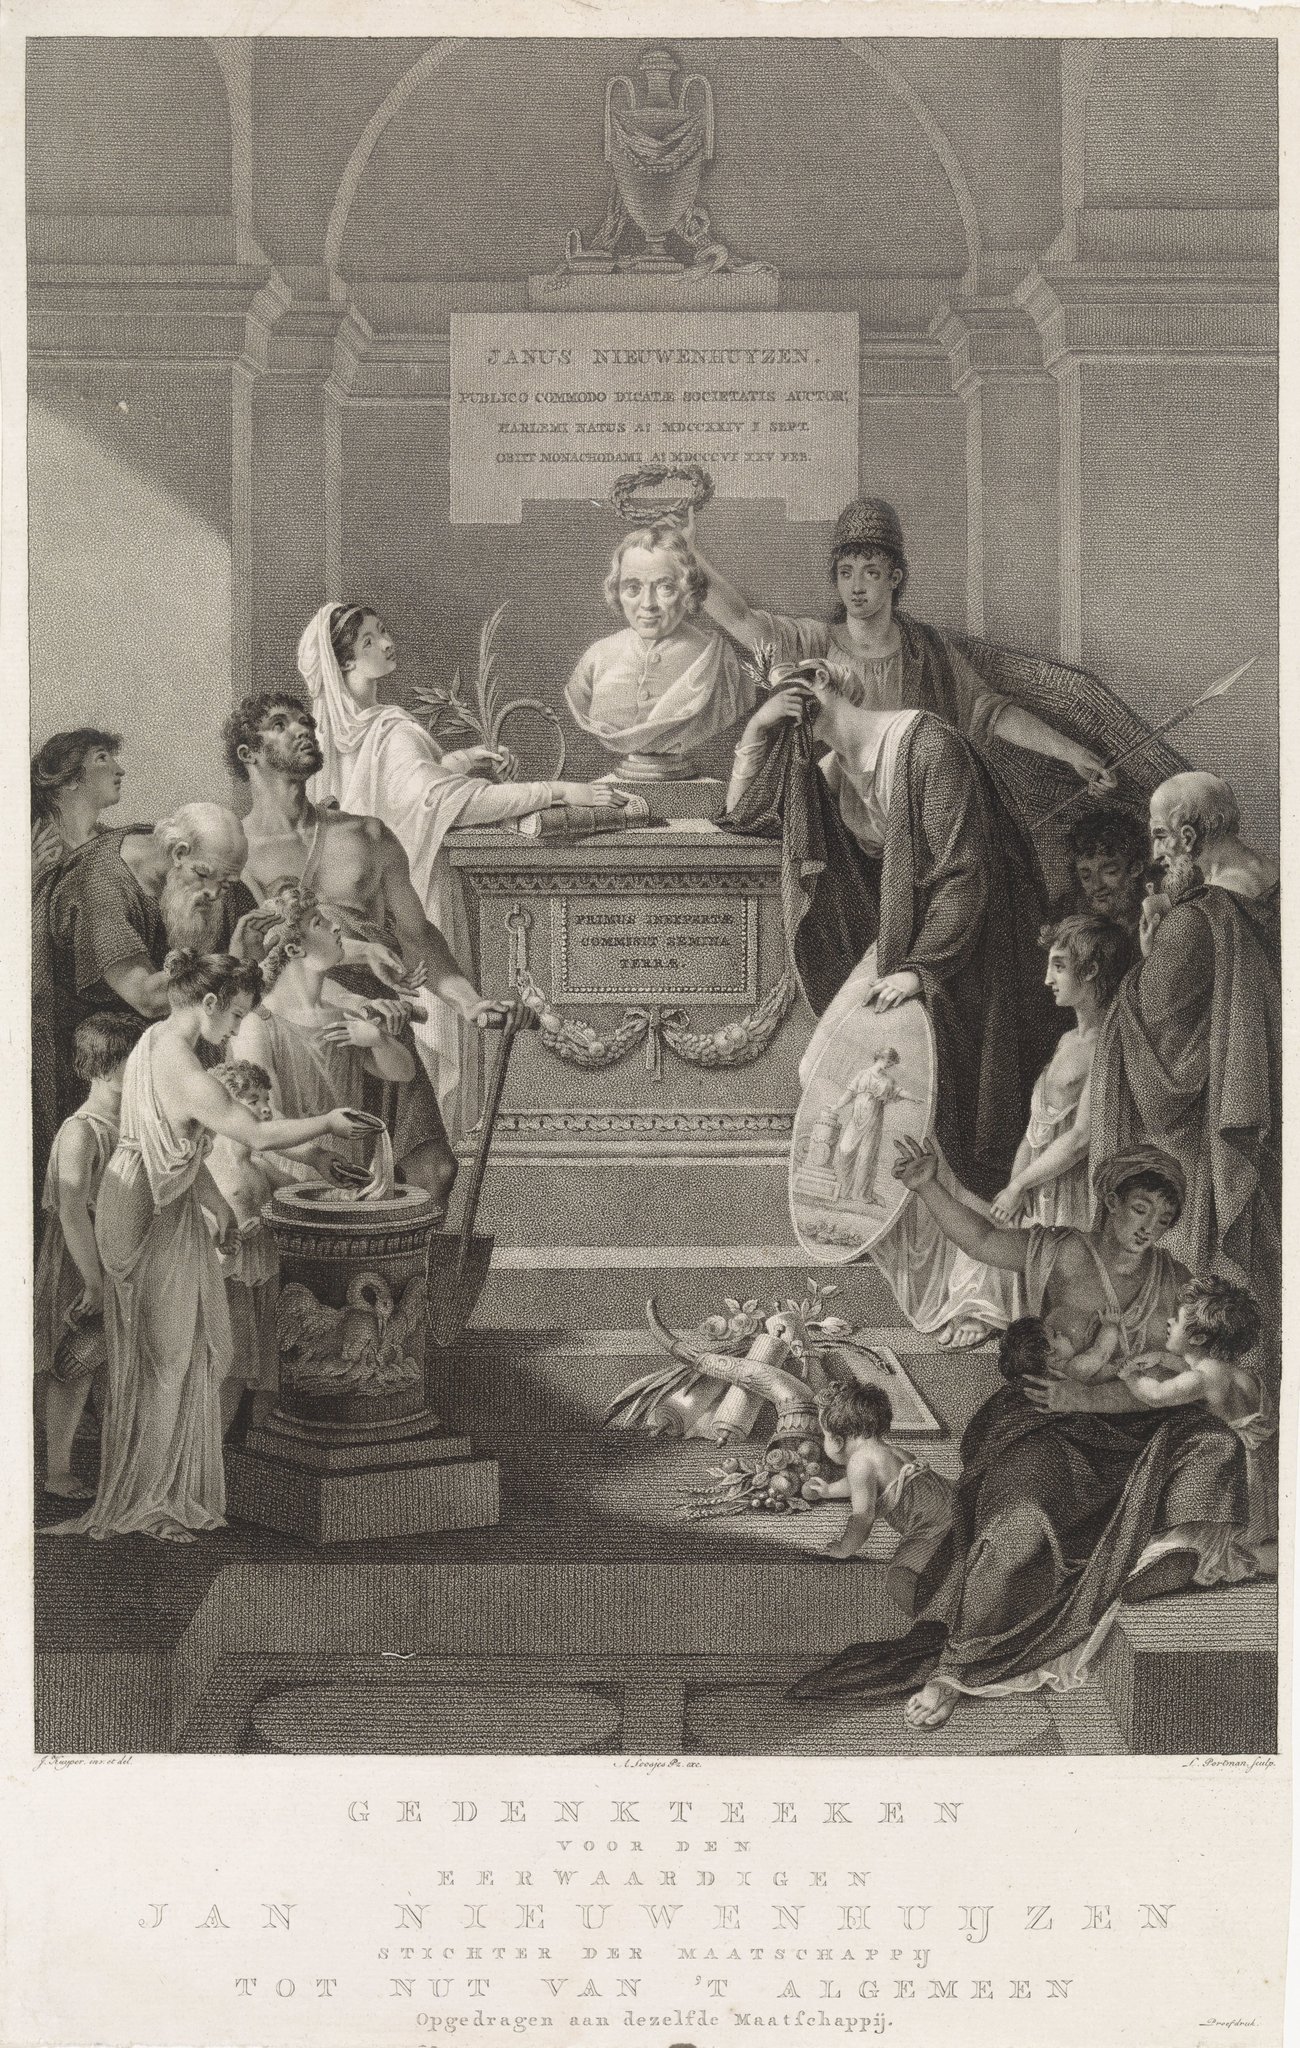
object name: print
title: Gedenkteeken voor den eerwaardigen Jan Nieuwenhuijzen stichter der maatschappij Tot nut van 't algemeen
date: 1806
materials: paper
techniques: etching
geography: amsterdam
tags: haarlem, jan nieuwenhuyzen, 'cornucopia', horn of plenty, charity, 'caritas'; 'carità' (ripa) ~ one of the three theological virtues, offering; 'offerta overo oblatione' (ripa) (+ allegorical scene, i.e. two or more personifications involved in an action), symbols, allegories of peace, 'pax'; 'pace' (ripa), serpent ouroboros, urn, crowning with laurel, love towards god; 'amore verso iddio' (ripa), grave, tomb and other grave-forms and grave-markers, youth, adolescence, 'iuventus'; 'adolescenza', 'gioventù' (ripa), the bible as a book, symbols of particular nations, states, districts, etc.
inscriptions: collector's mark: Lugt 2228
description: Gedenksteen voor Jan Nieuwenhuyzen, overleden 25 februari 1806. Op een altaar in een nis staat de buste van Jan Nieuwenhuyzen, stichter van de Maatschappij Tot Nut van 't Algemeen. Daarboven een kader met de naam, geboorte- en sterfdatum van Nieuwenhuyzen. Op het altaar een motto in het Latijn (Hij plantte daar niets stond). De buste wordt gelauwerd door de Hollandse Maagd. Voor haar de personificatie van de Maatschappij die haar betraande gezicht bedekt en leunt op het altaar en haar schild. Aan de andere kant van het altaar kijkt de Godsvrucht op naar de buste. Haar hand rust op een bijbel (Zaligheid), in de andere houdt zij de slang die in zijn eigen staart bijt (Eeuwigheid) en een palmtak (Vrede). Een jonge vrouw, die de Jeugd symboliseert, offert op het altaar van Dankbaarheid. Op de voorgrond zit Liefde, die wijst op de buste van de stichter. Een van de kinderen reikt naar de vruchten uit de hoorn des overvloeds (het kind plukt reeds de vruchten van de stichting van de Maatschappij).